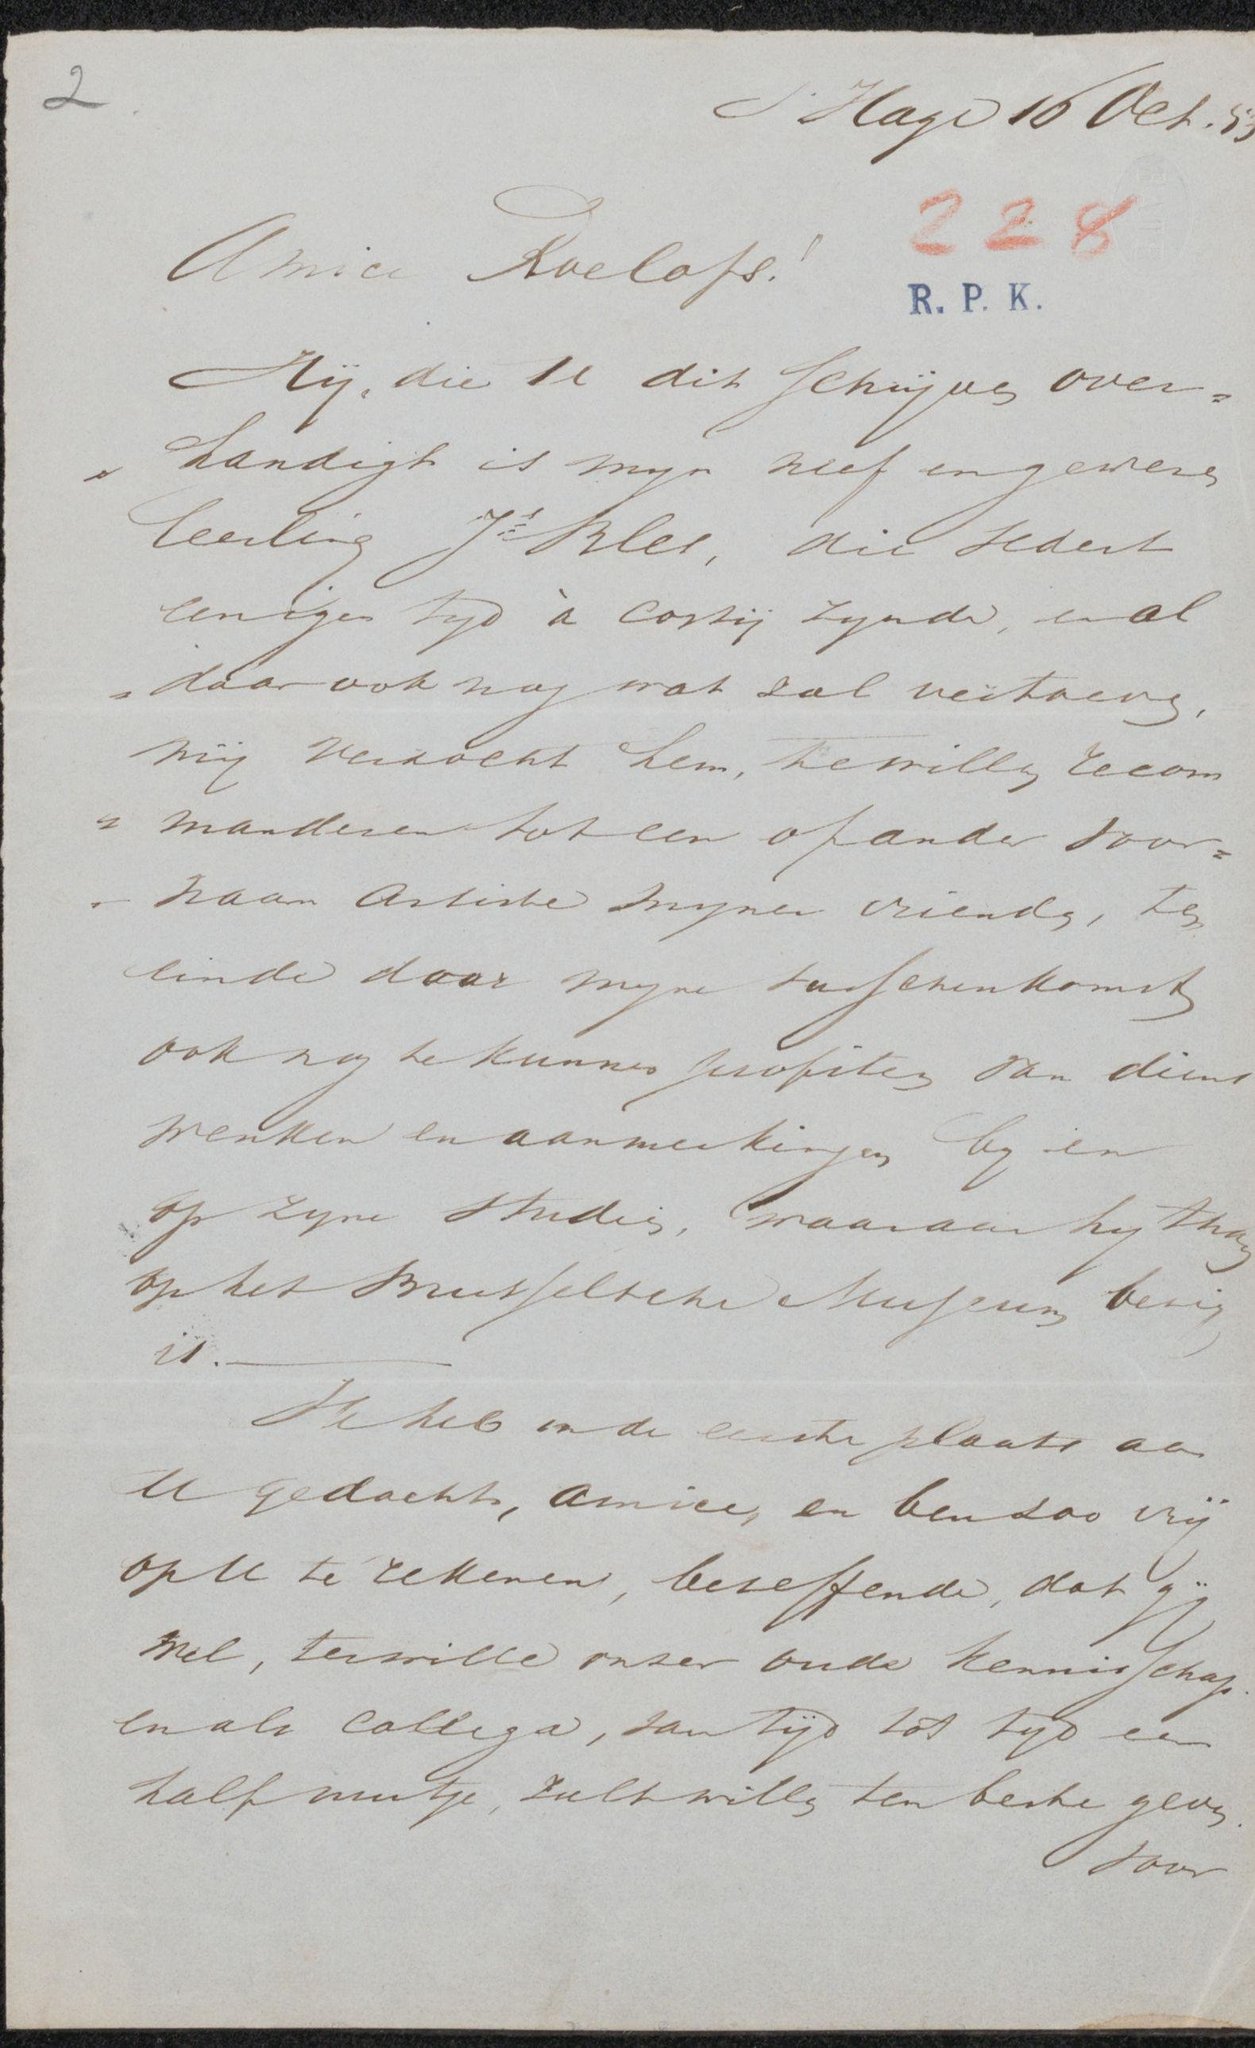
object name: letter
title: Brief aan Willem Roelofs (I)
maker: david bles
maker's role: draughtsman, painter, print maker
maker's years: 1821-1899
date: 1853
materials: ink, paper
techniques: pen, writing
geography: the hague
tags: amsterdam, willem roelofs (i), education, tuition of the artist (in general), brussels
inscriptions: collector's mark: Lugt 2233